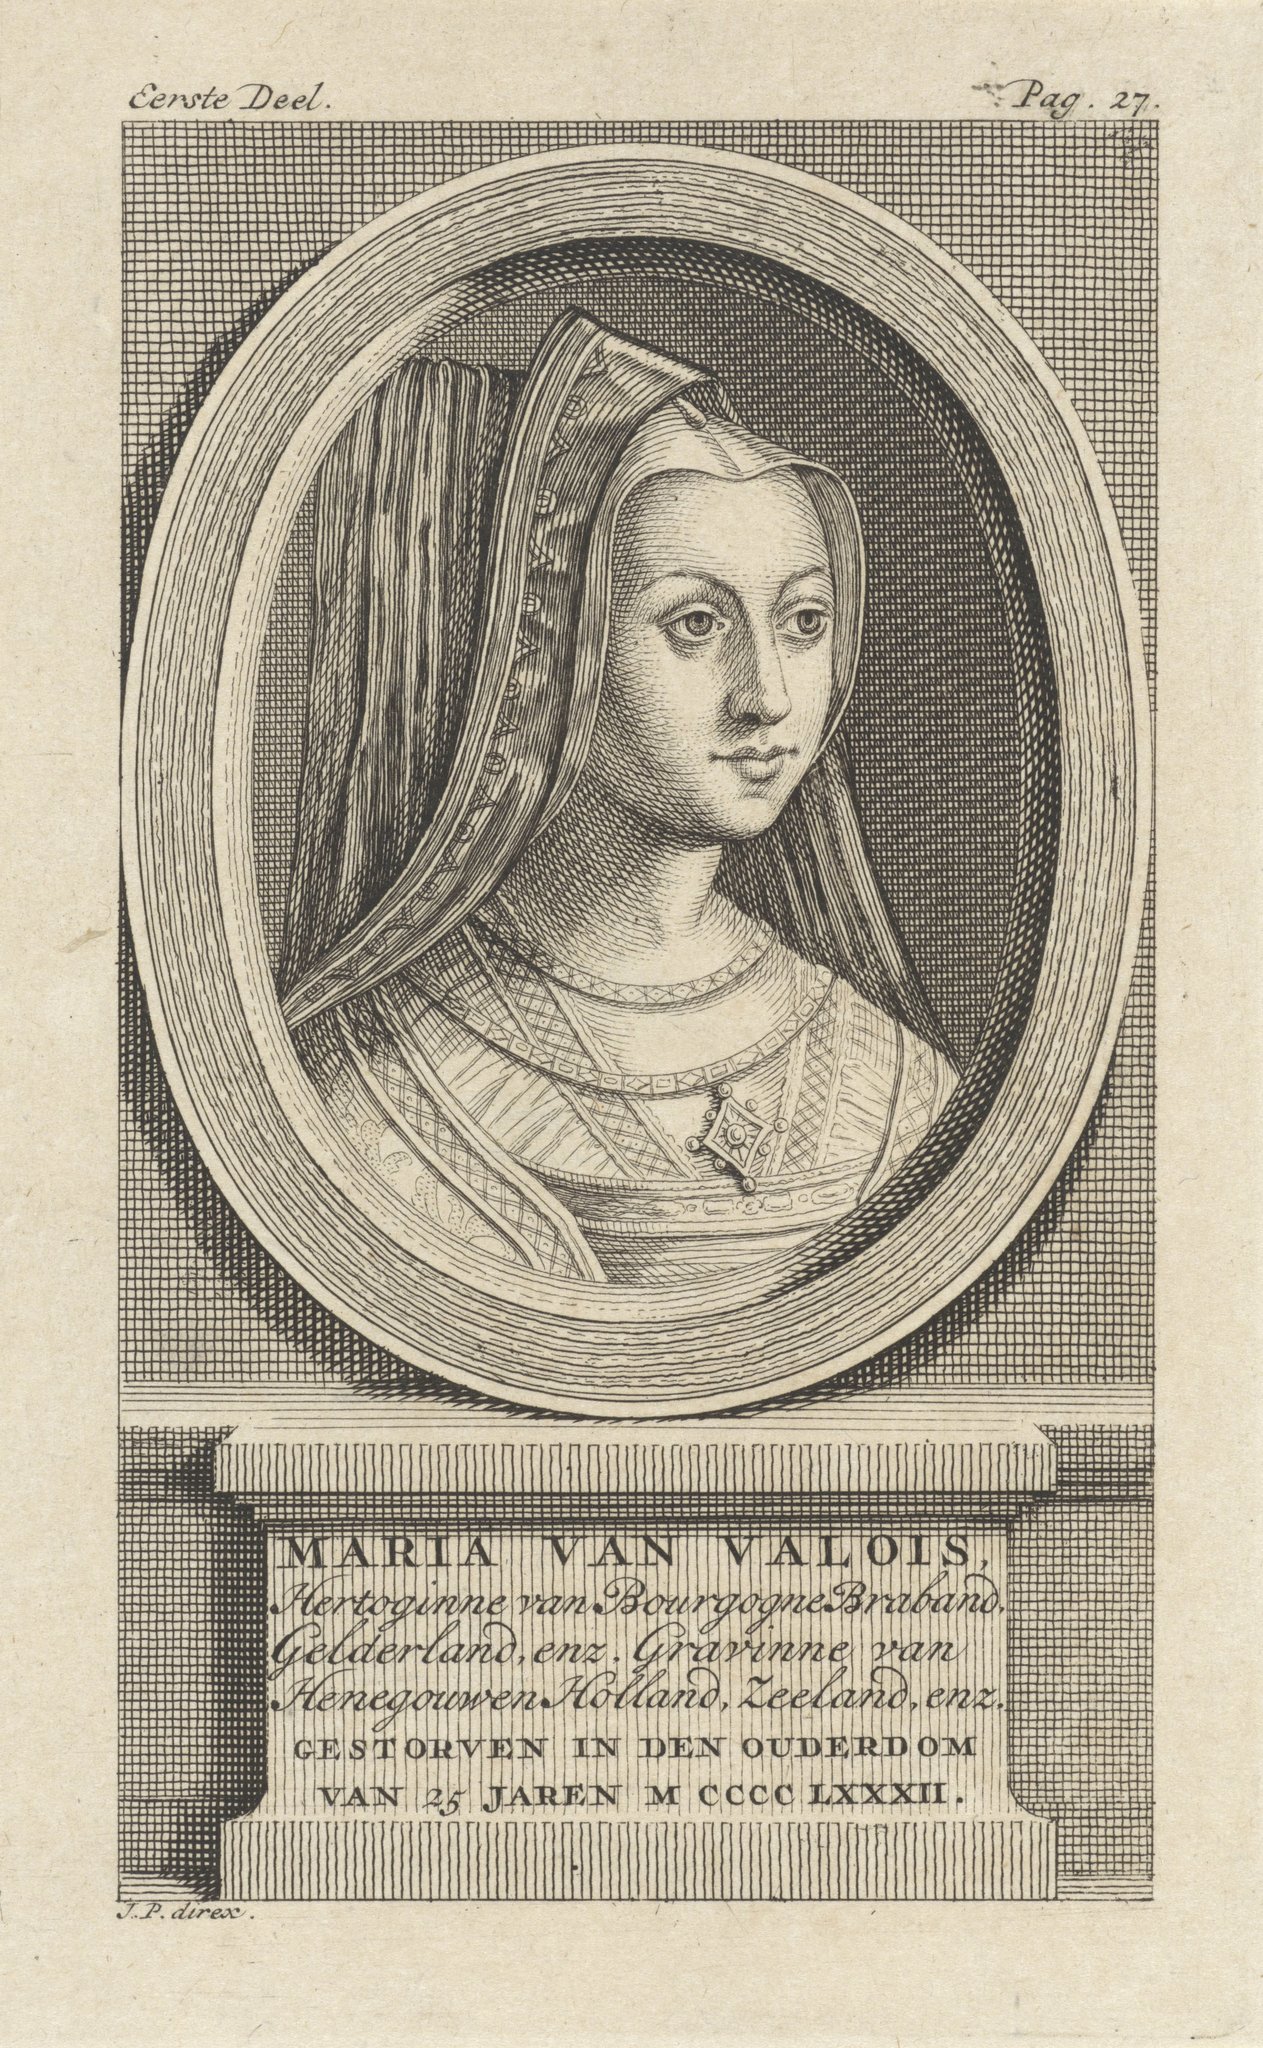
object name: book illustration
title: Portret van Maria, hertogin van Bourgondië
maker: jan punt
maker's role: draughtsman, print maker, publisher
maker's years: 1711-1779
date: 1748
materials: paper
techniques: engraving, etching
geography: northern netherlands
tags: brussels, bruges, maria (hertogin van bourgondië)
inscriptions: collector's mark: Lugt 2228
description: Illustratie uit: Meteren, Emanuel van. Historie van de oorlogen en geschiedenissen der Nederlanderen, en der zelver naburen: beginnende met den jare 1315, en eindigende met den jare 1611, deel I, p. 27. Gorinchem/Breda: Nicolaas Goetzee, Pieter Goetzee/Willem Goetzee, 1748.